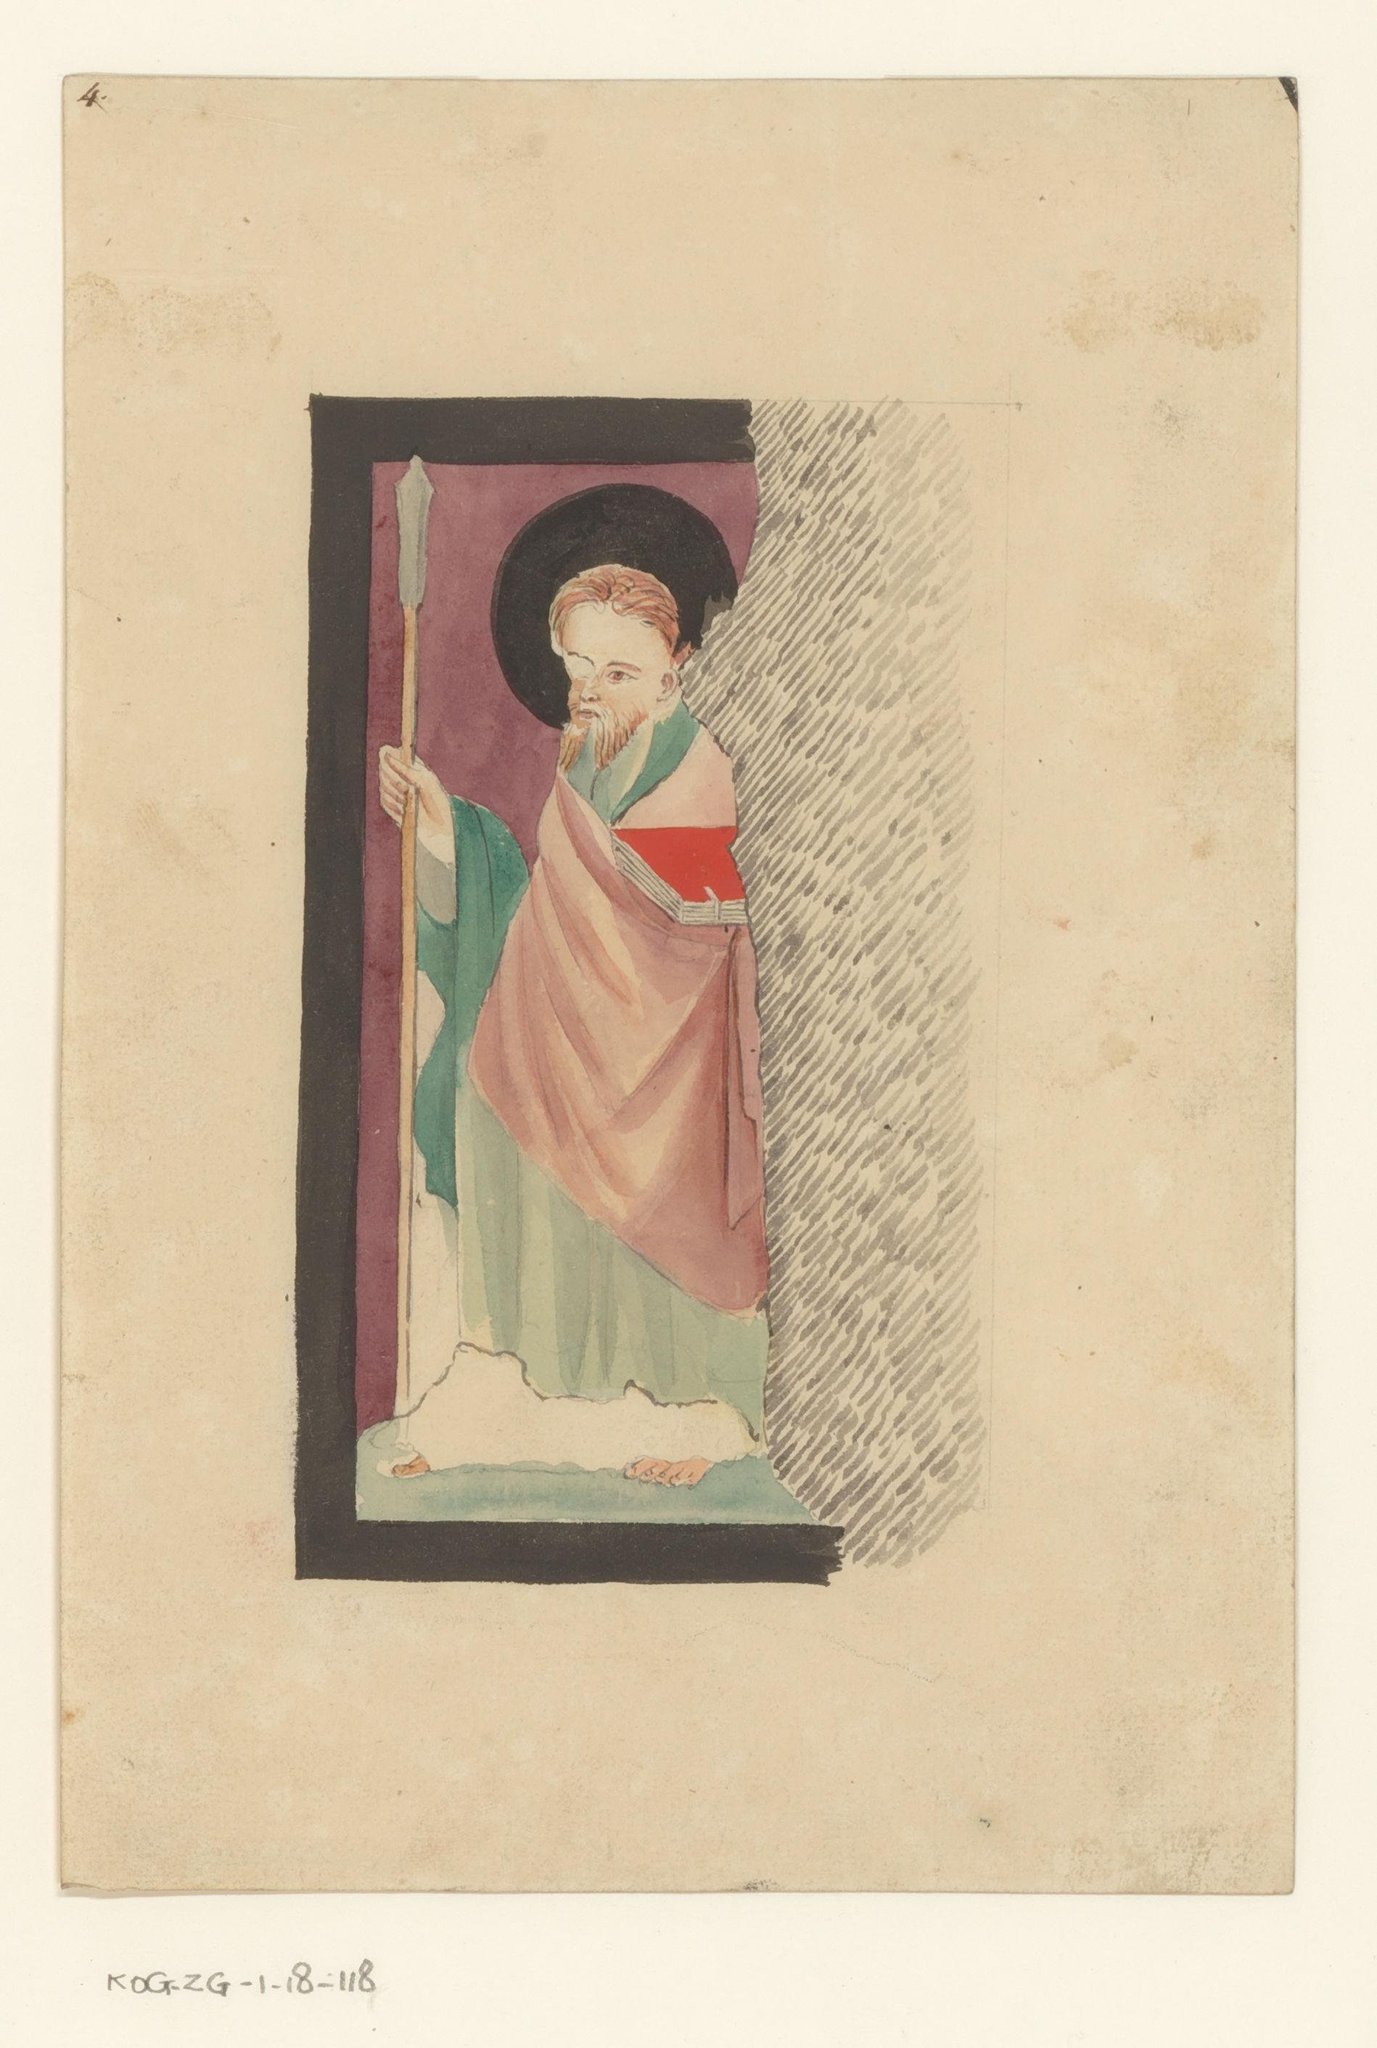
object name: drawing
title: Matteüs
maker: tiemen hooiberg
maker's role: painter, print maker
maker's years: 1809-1897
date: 1844-1846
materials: ink, paper, watercolor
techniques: brush, pen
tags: the apostle and evangelist matthew (mattheus); possible attributes: angel, axe, book, halberd, pen and inkhorn, purse, scroll, square, sword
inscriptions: stamp, collector's mark: Lugt 1641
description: Getekend naar de vijftiende-eeuwse secco muurschildering in het koor van de Pieterskerk in Leiden. De muurschilderingen werden herontdekt in 1844.